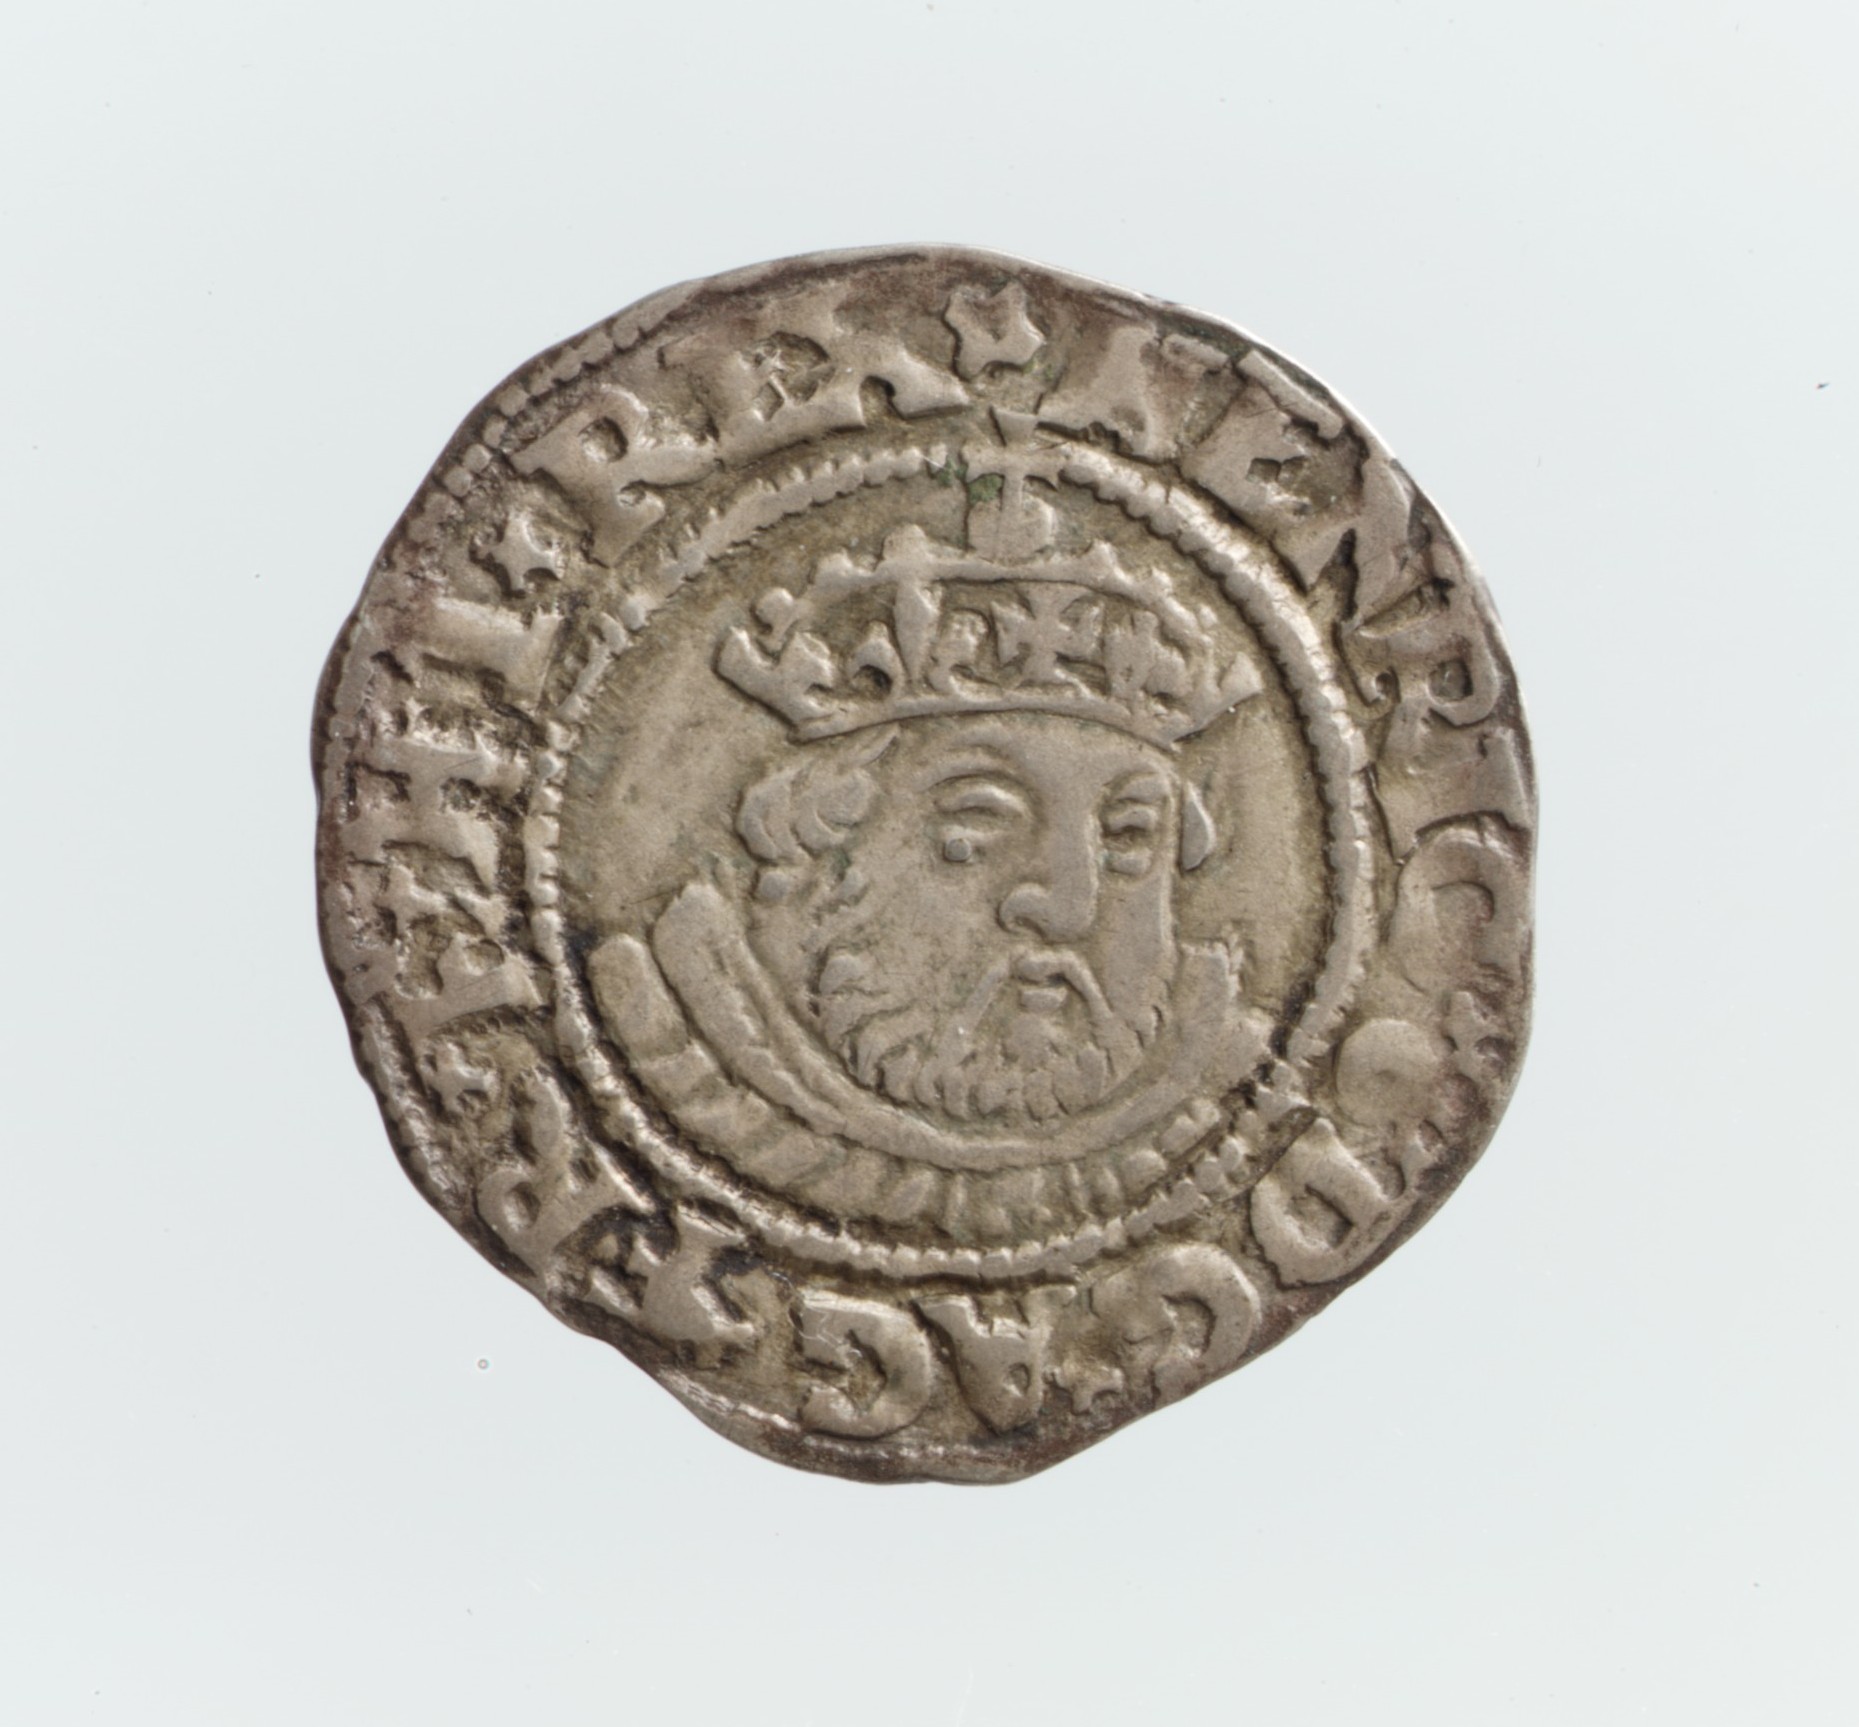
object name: half groat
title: Half groat of Henry VIII (r. 1509–47)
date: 1544-1547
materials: silver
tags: henry viii,portraits,coat of arms